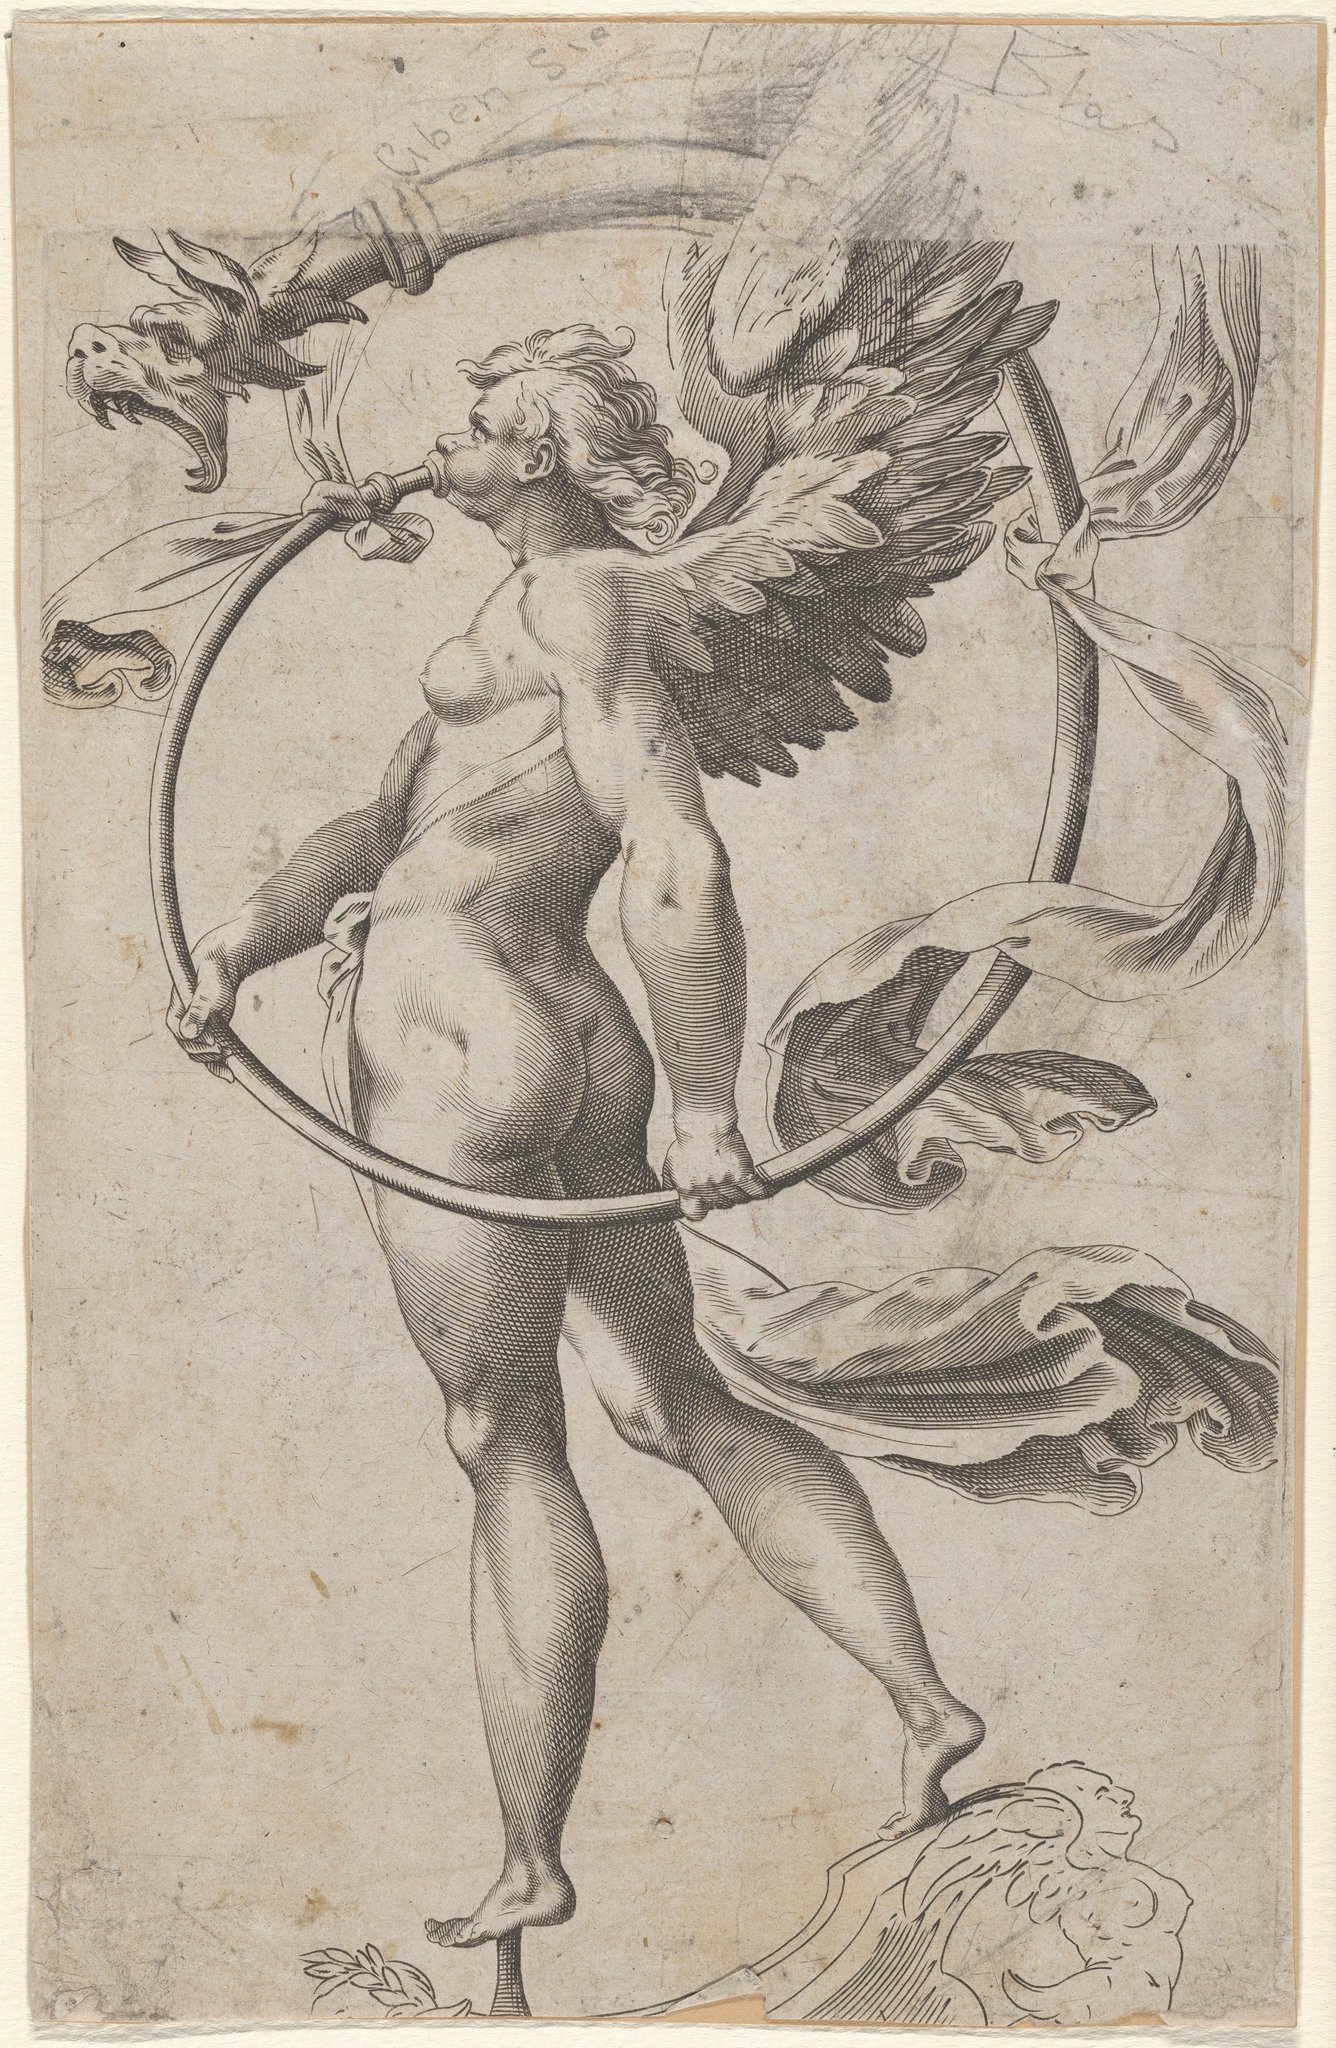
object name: print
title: A winged figure of Fame standing facing left and sounding a trumpet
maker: cherubino alberti (zaccaria mattia)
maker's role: artist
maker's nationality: italian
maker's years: 1553-1615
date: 1570-1615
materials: graphite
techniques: cutting, engraving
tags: trumpets